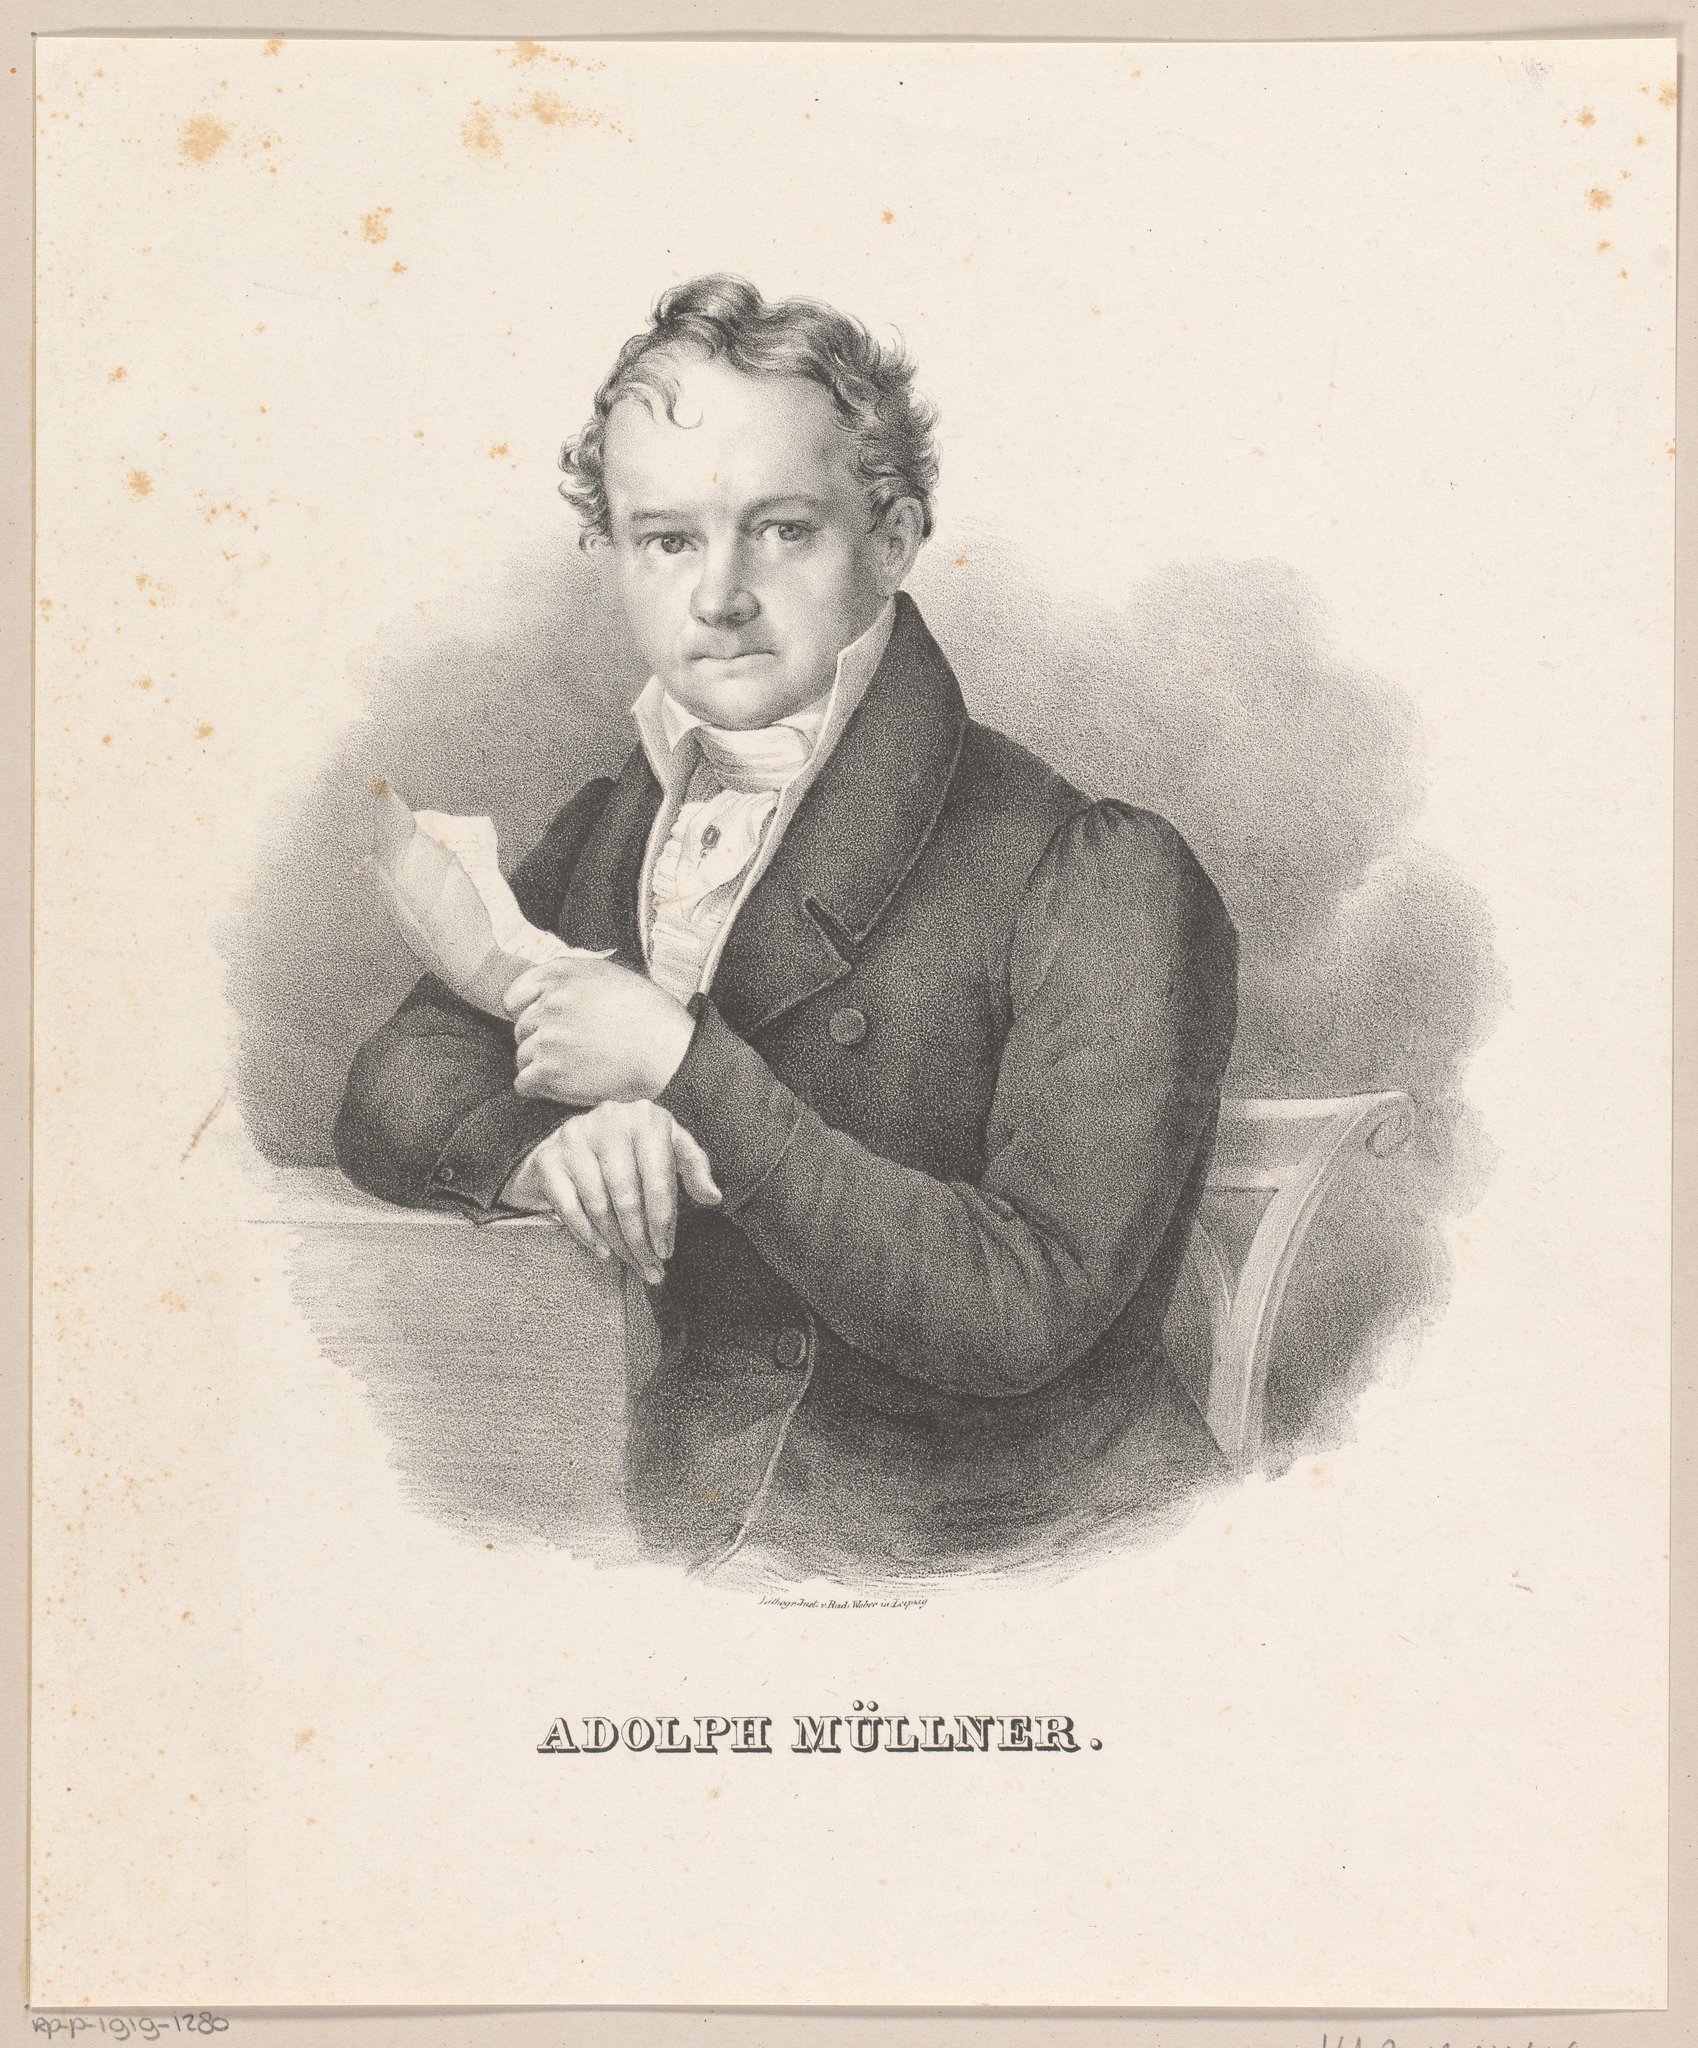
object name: print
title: Adolph Müllner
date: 1800-1900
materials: paper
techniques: lithograph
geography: vienna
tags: historical persons, lawyer, attorney at law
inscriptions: collector's mark: Lugt 2228